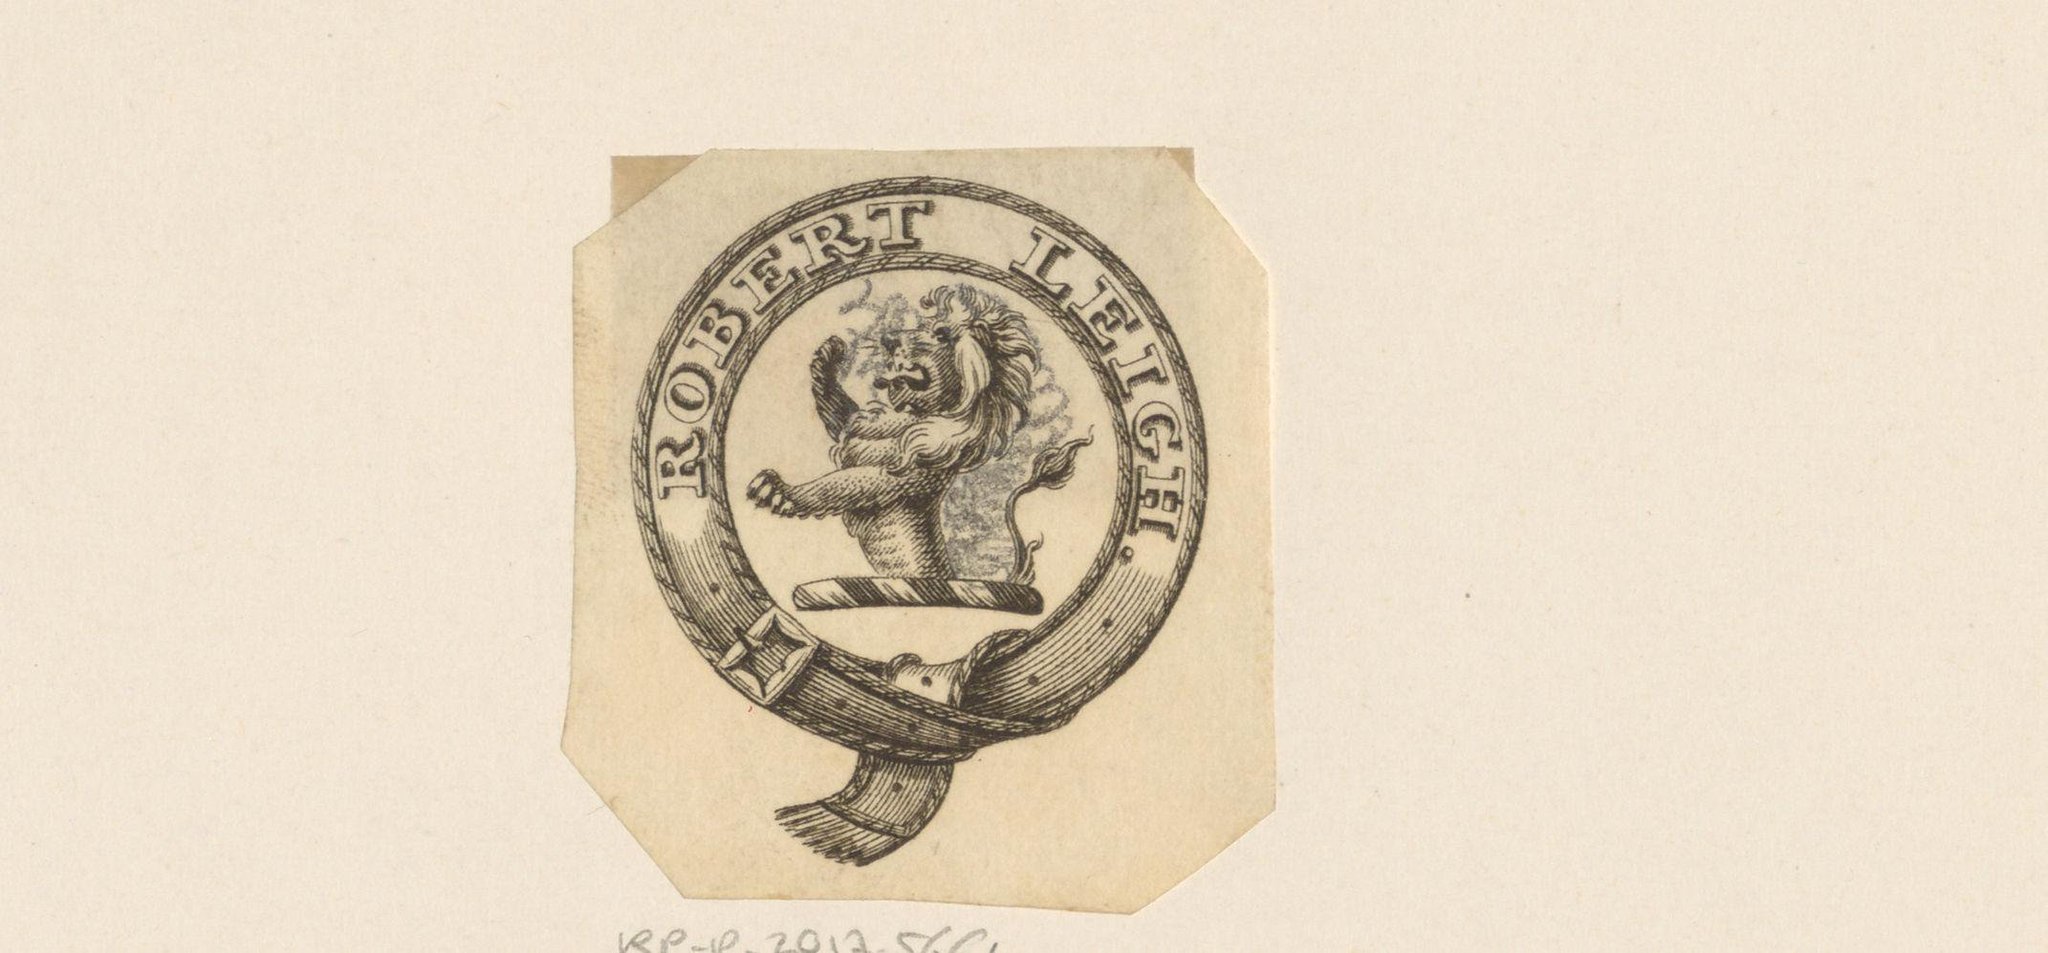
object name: bookplate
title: Ex libris van Robert Leigh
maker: Anonymous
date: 1800-1899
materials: paper, pencil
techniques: drawing, etching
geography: england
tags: belt, girdle, waistband, beasts of prey, predatory animals: lion